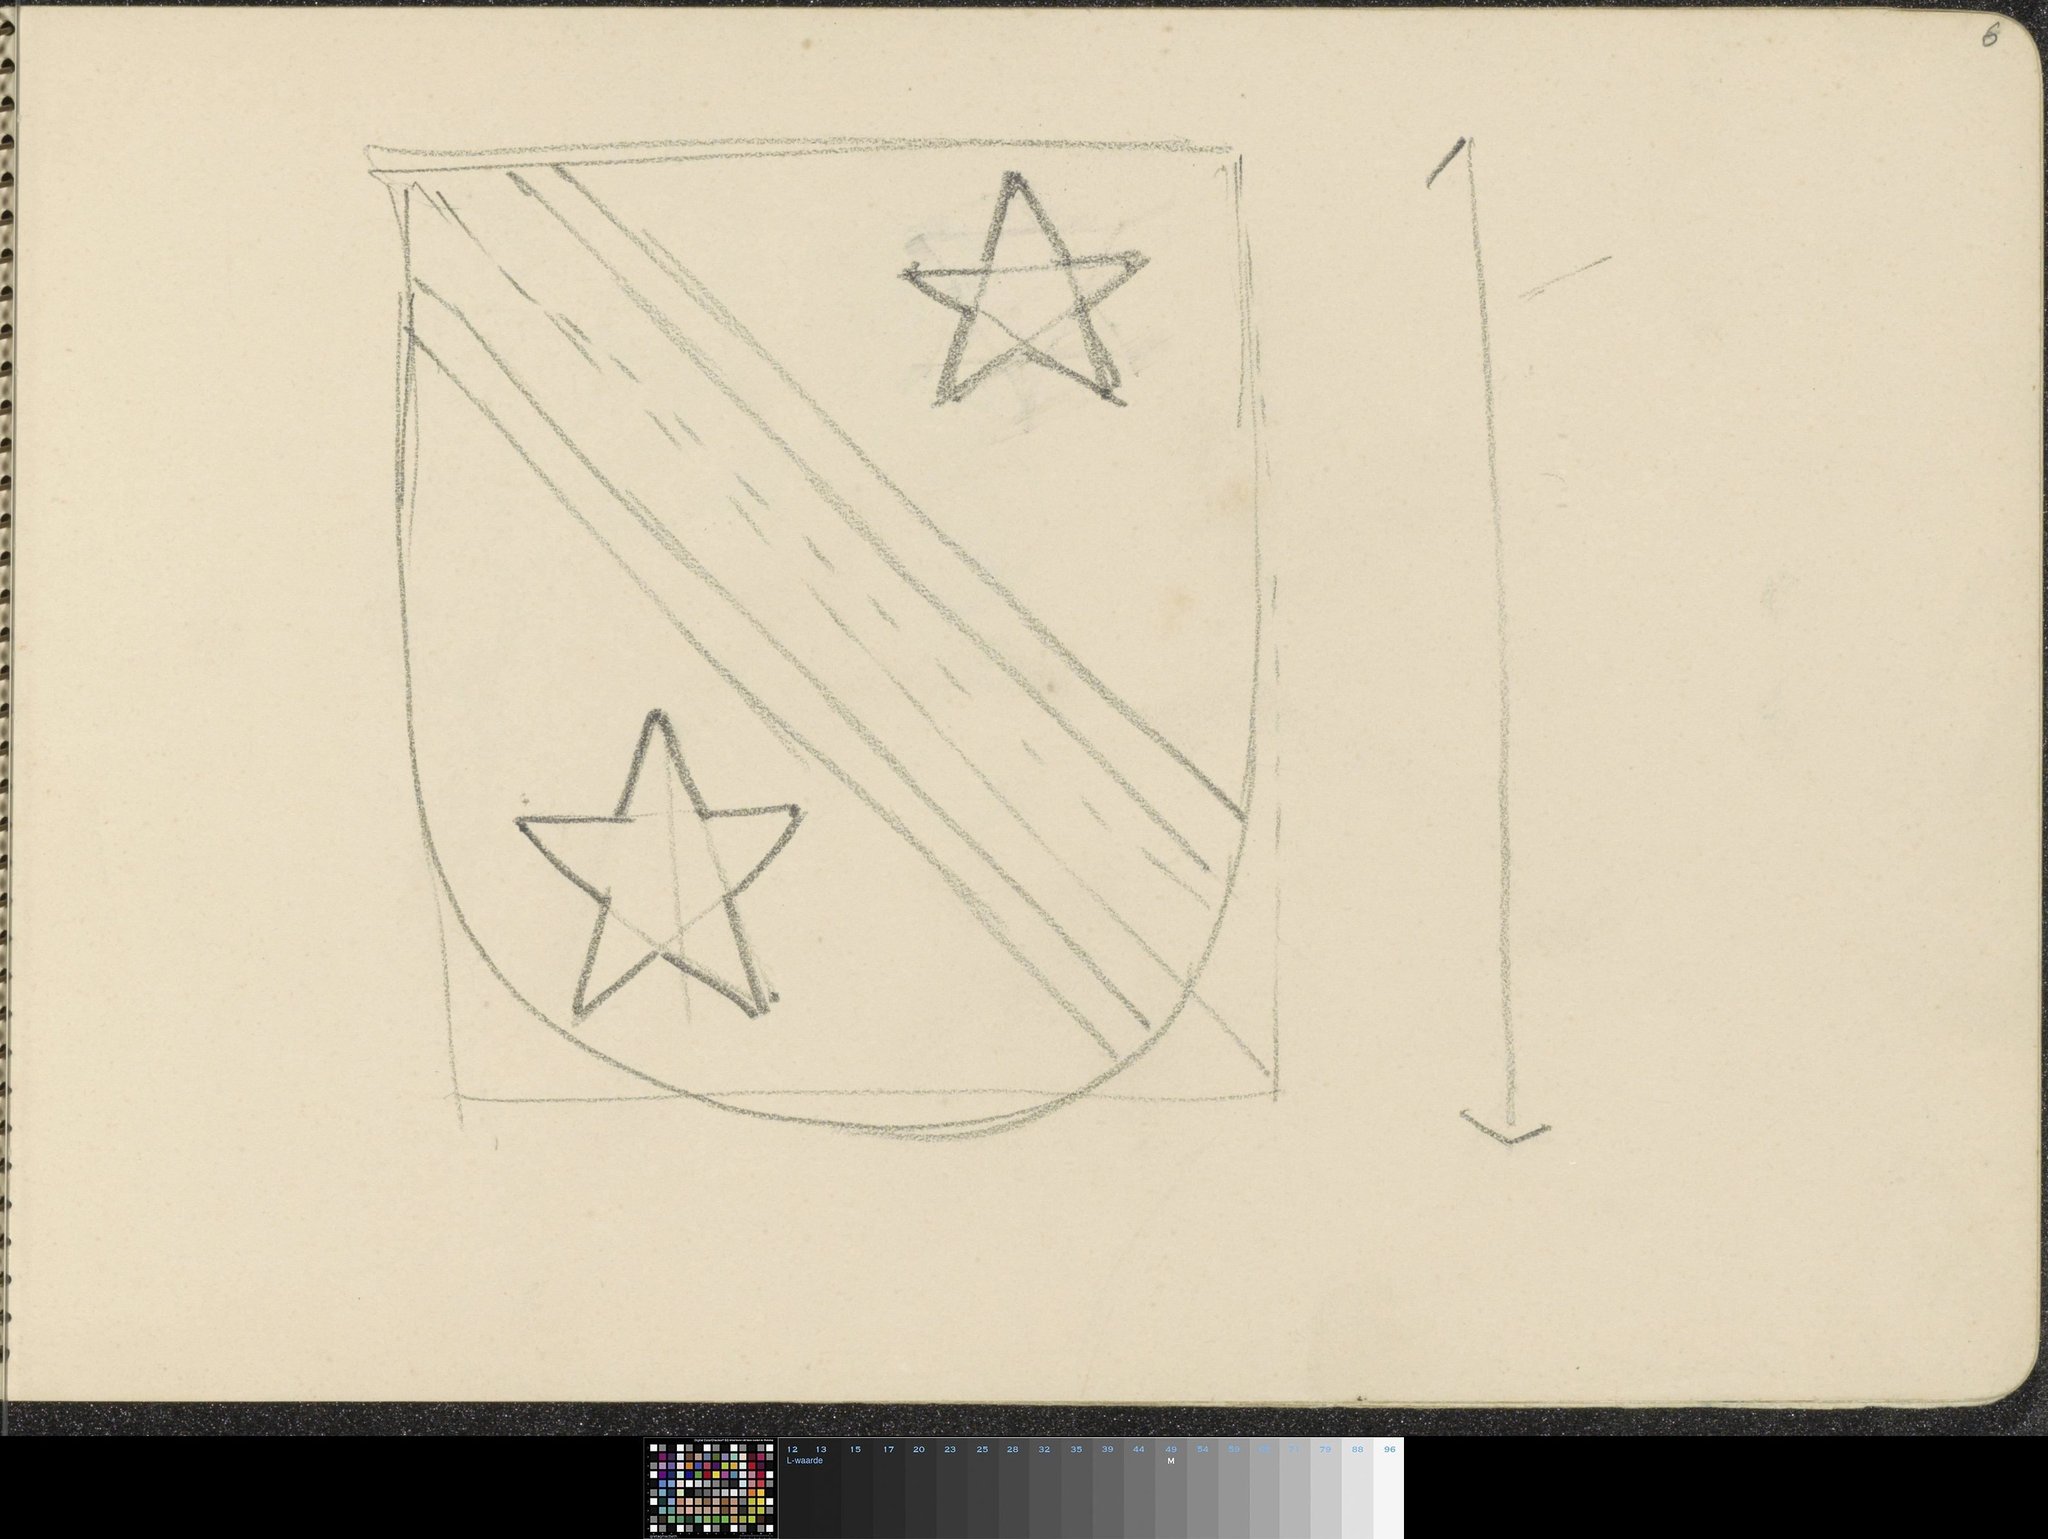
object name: sketchbook leaf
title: Ontwerp voor een wapen met twee sterren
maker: carel adolph lion cachet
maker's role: draughtsman, print maker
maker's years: 1864-1945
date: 1934-1943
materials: paper, pencil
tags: coat of arms (as symbol of the state, etc.)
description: Blad 6 recto uit een schetsboek met 19 bladen.